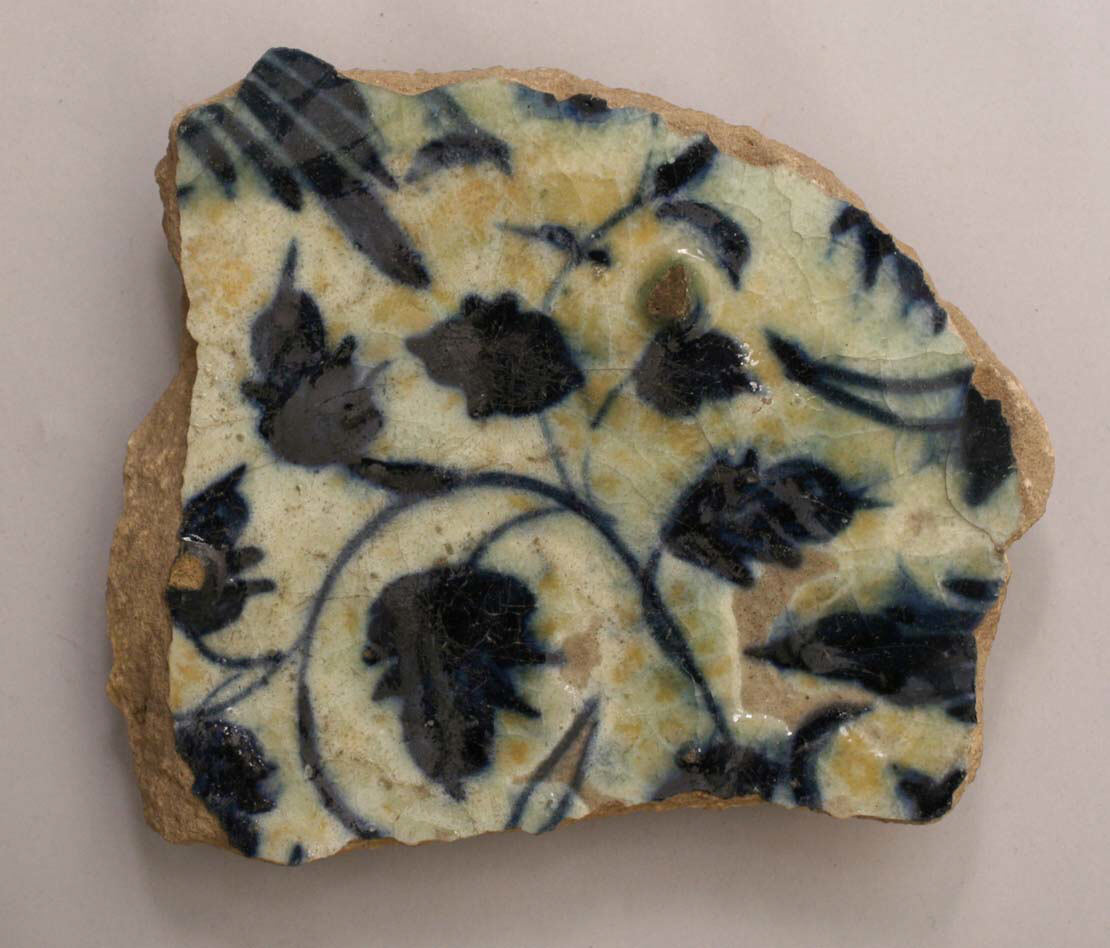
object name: ceramic fragment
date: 1401-1500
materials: glaze, stonepaste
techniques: painting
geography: egypt or syria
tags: leaves